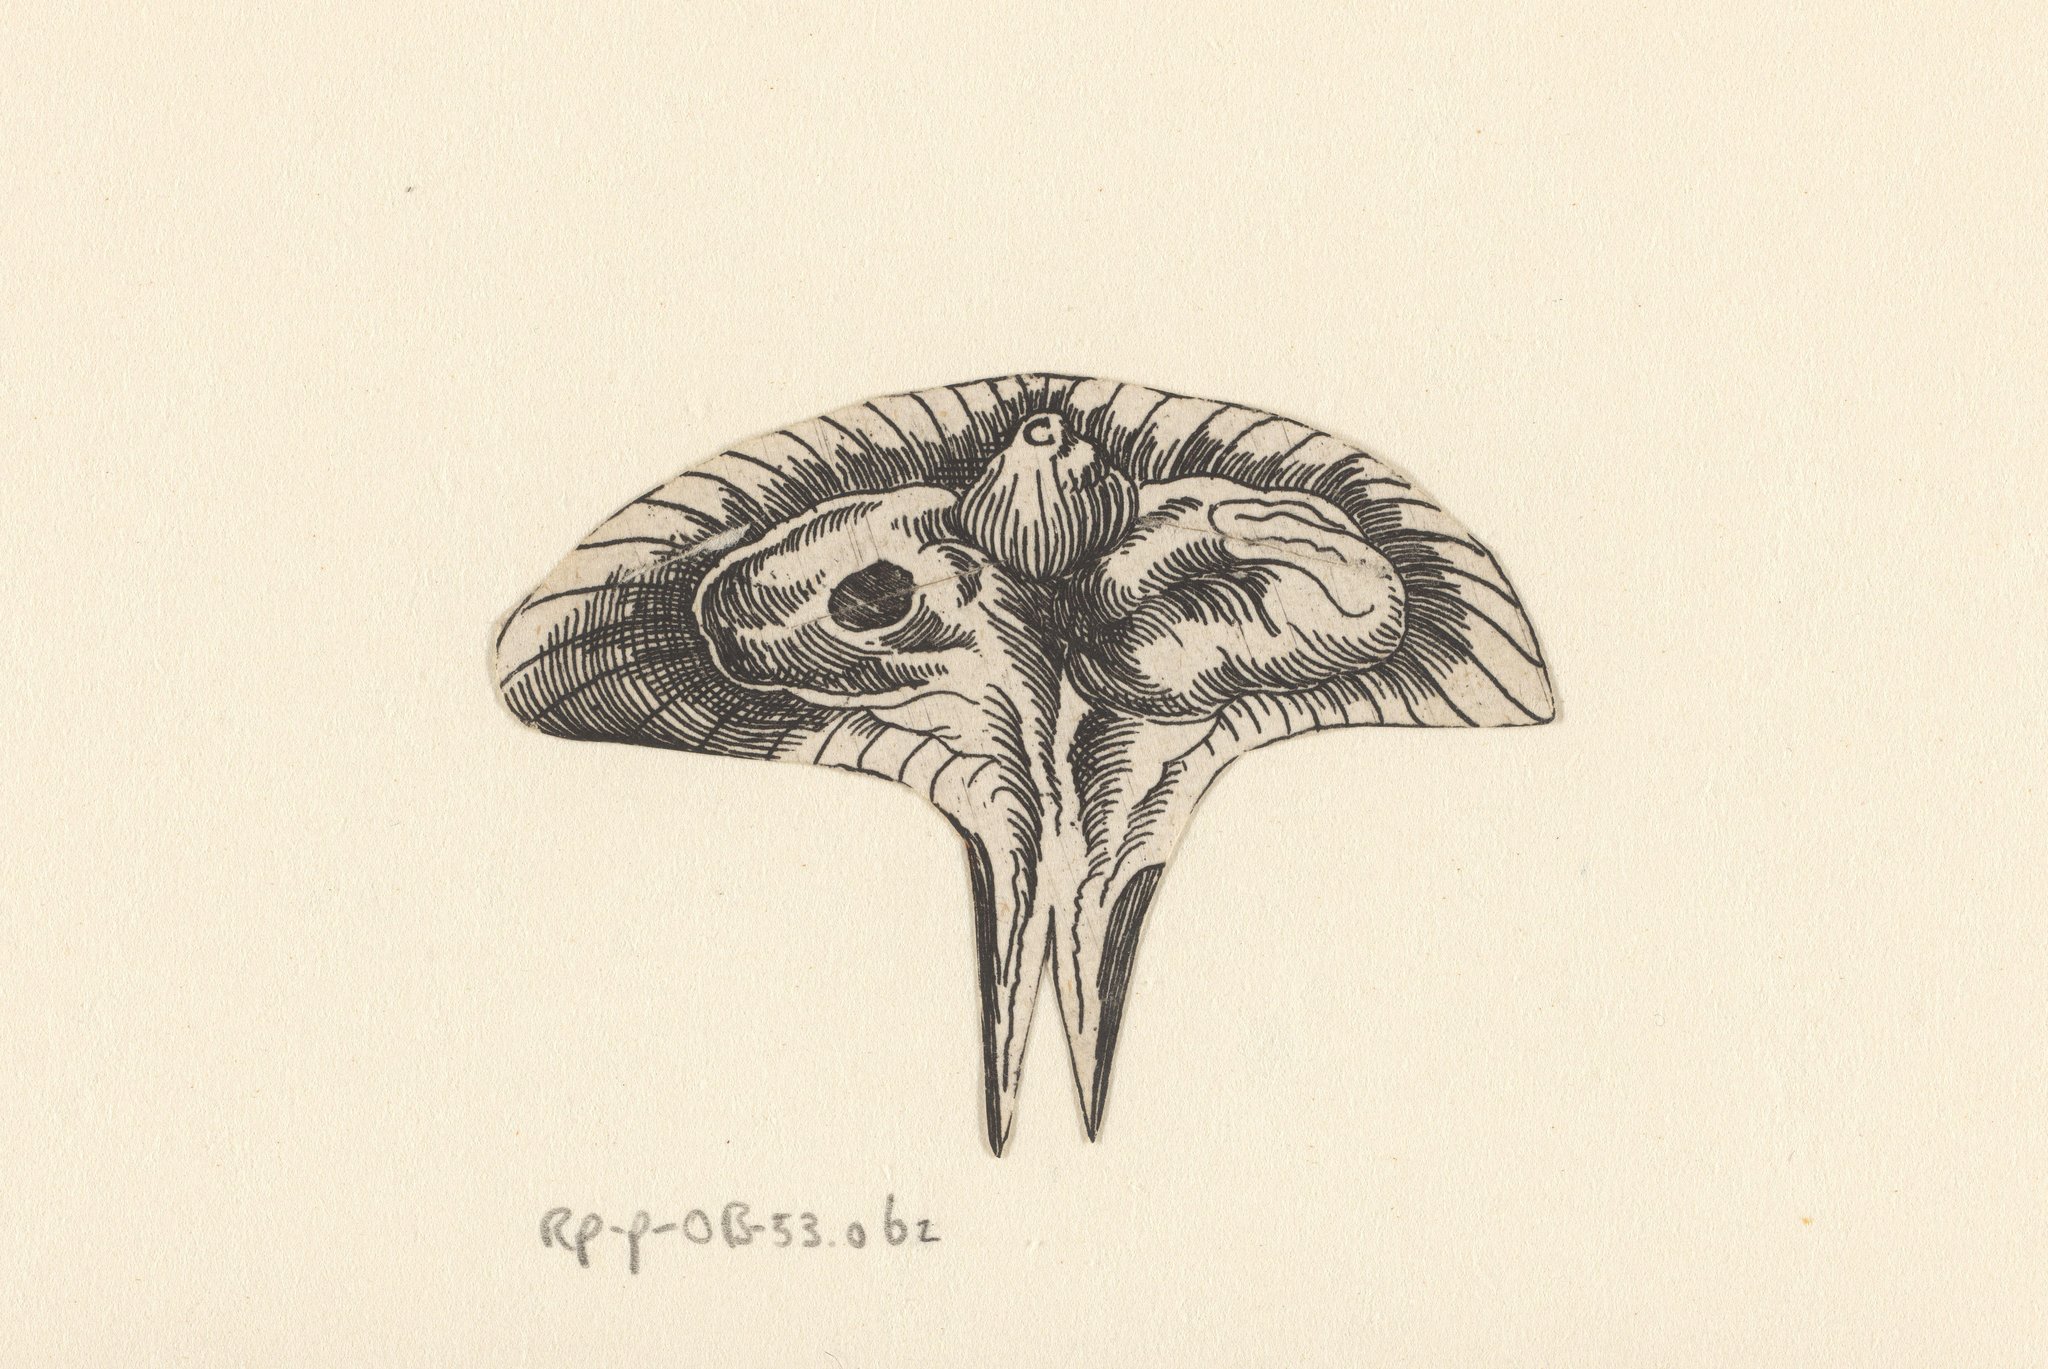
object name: print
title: Dwarsdoorsnede baarmoeder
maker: lucas kilian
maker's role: draughtsman, print maker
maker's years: 1579-1637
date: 1589-1637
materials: paper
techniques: etching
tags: organ, womb, uterus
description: Suzanne Karr Schmidt suggereert dat deze prenten van losse en uitneembare (dus niet geplakte) organen onderdeel waren van de Visio Secundae en Visio Tertia van Johann Remmelin's 'Catoptrum Microcosmicum' uit 1619.